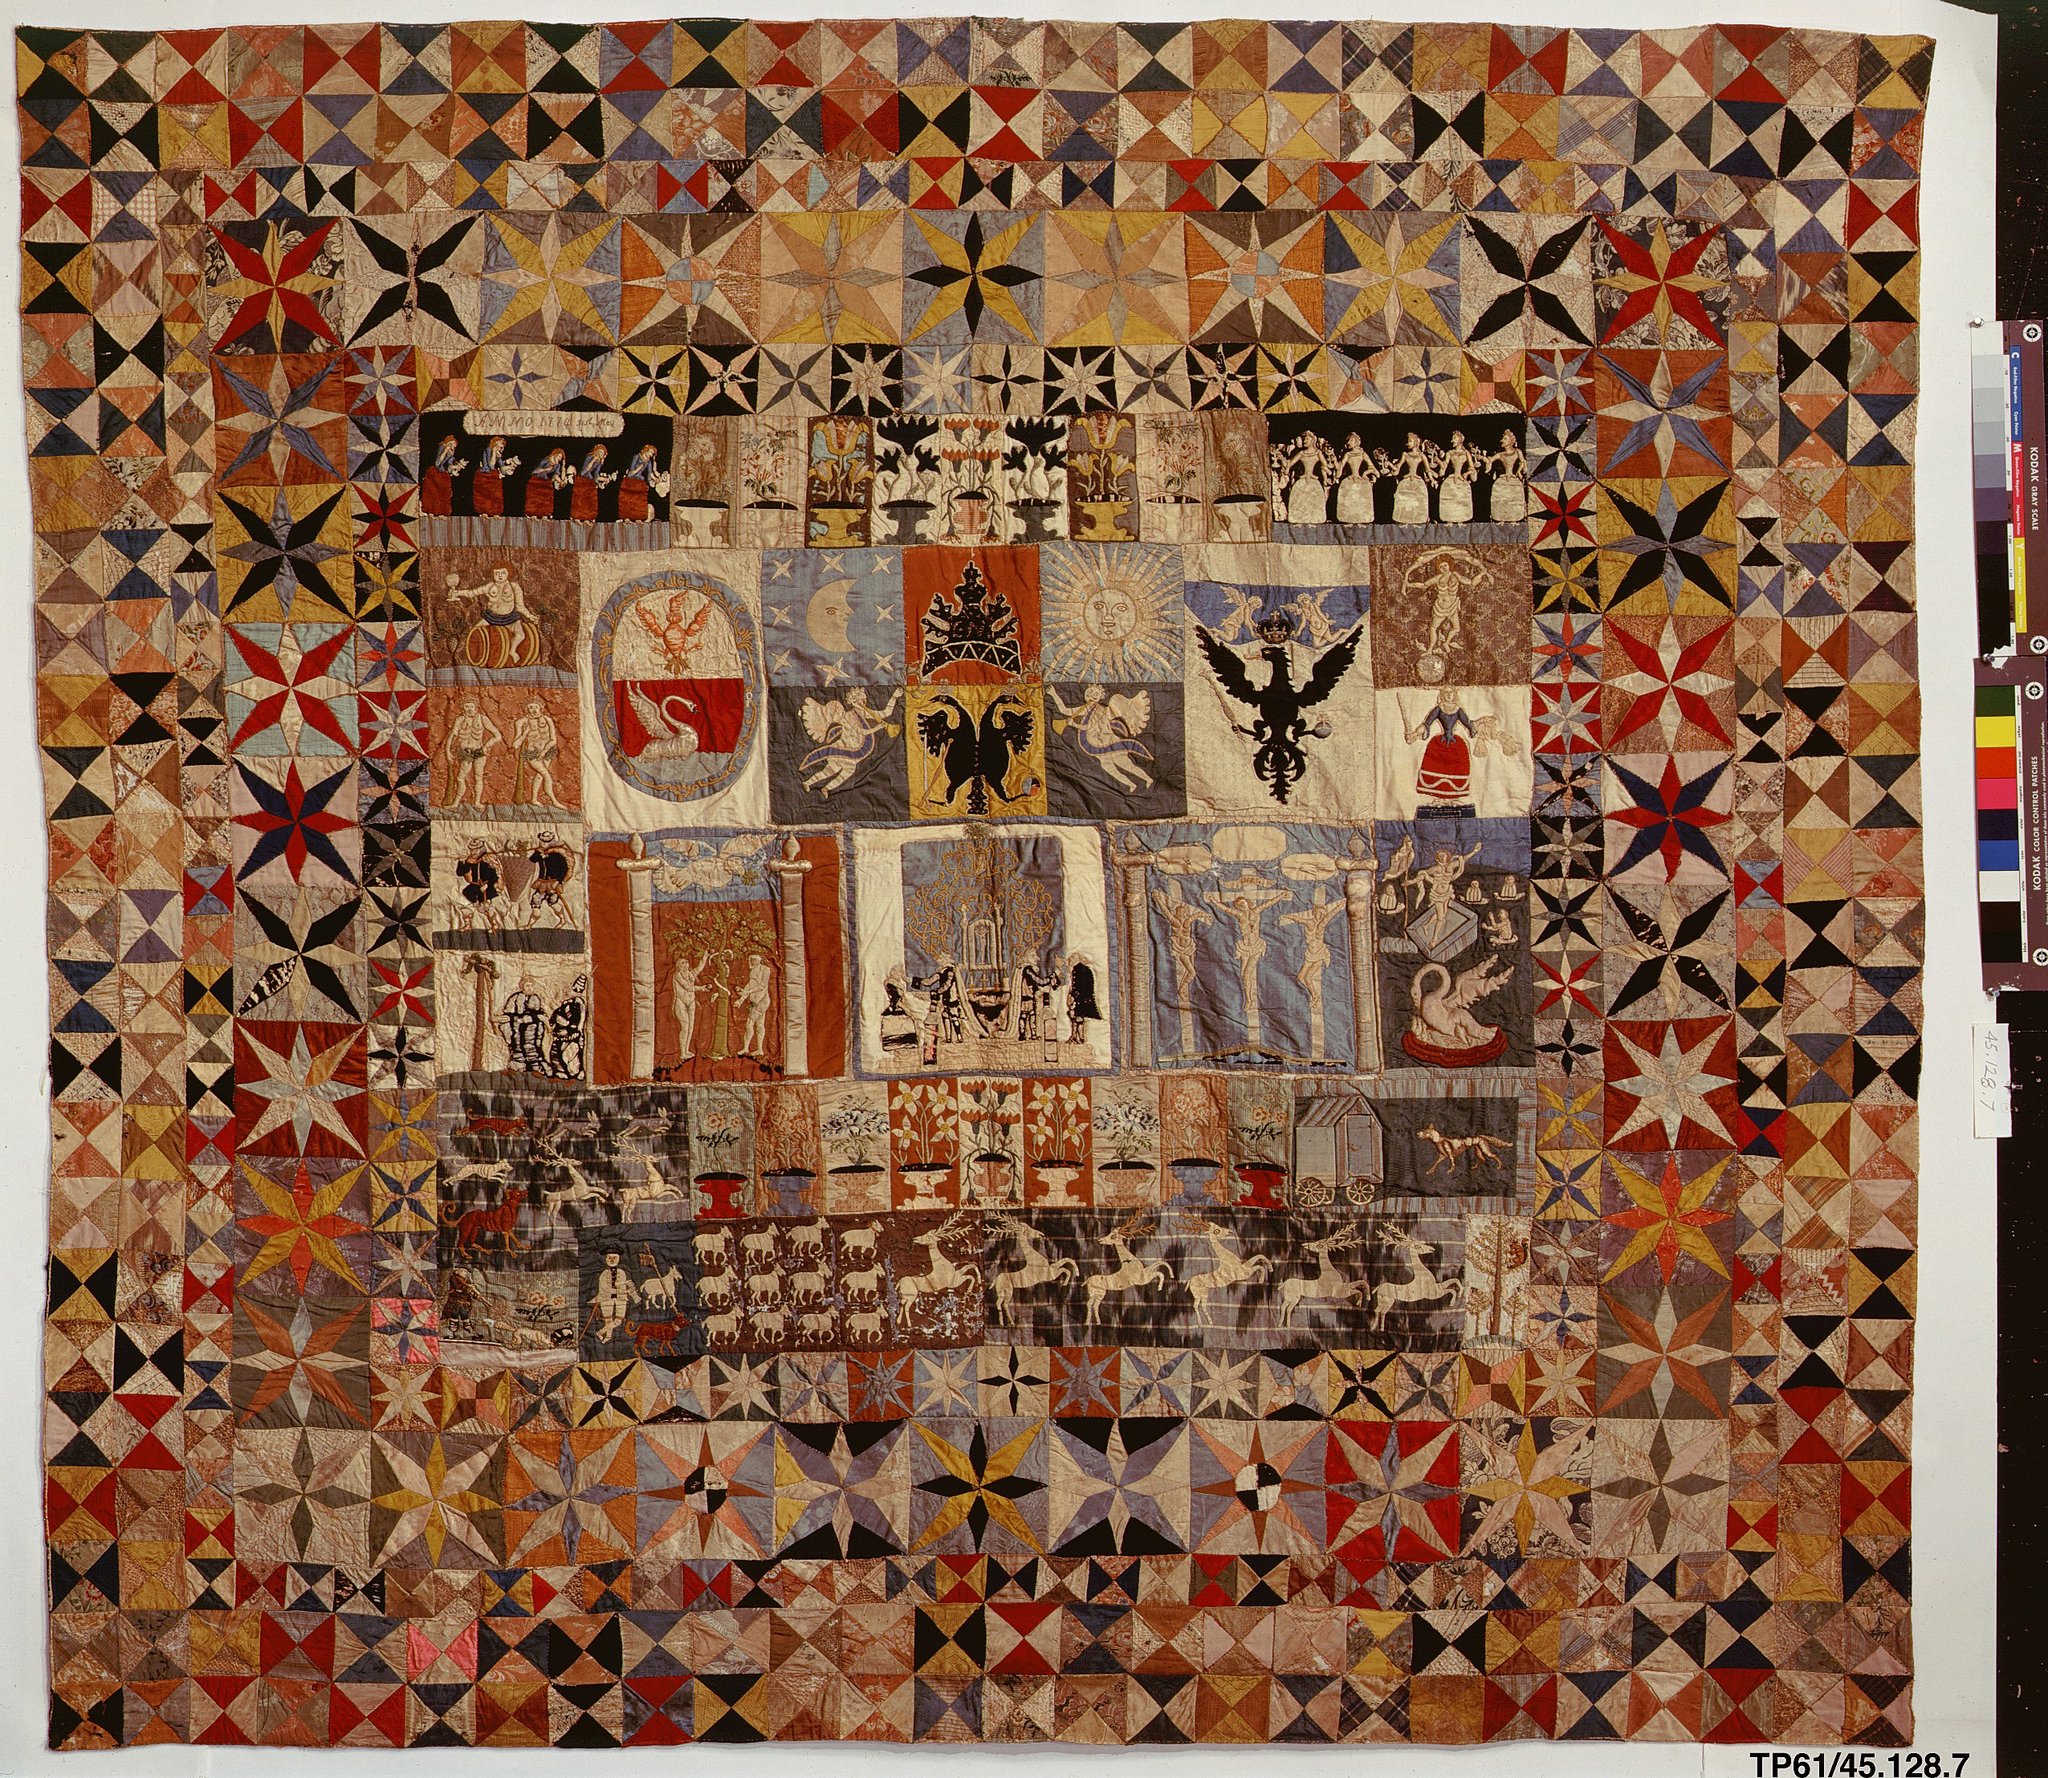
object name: cover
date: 1774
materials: silk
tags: eagles,swans,deer,dogs,adam,eve,crucifixion,coat of arms